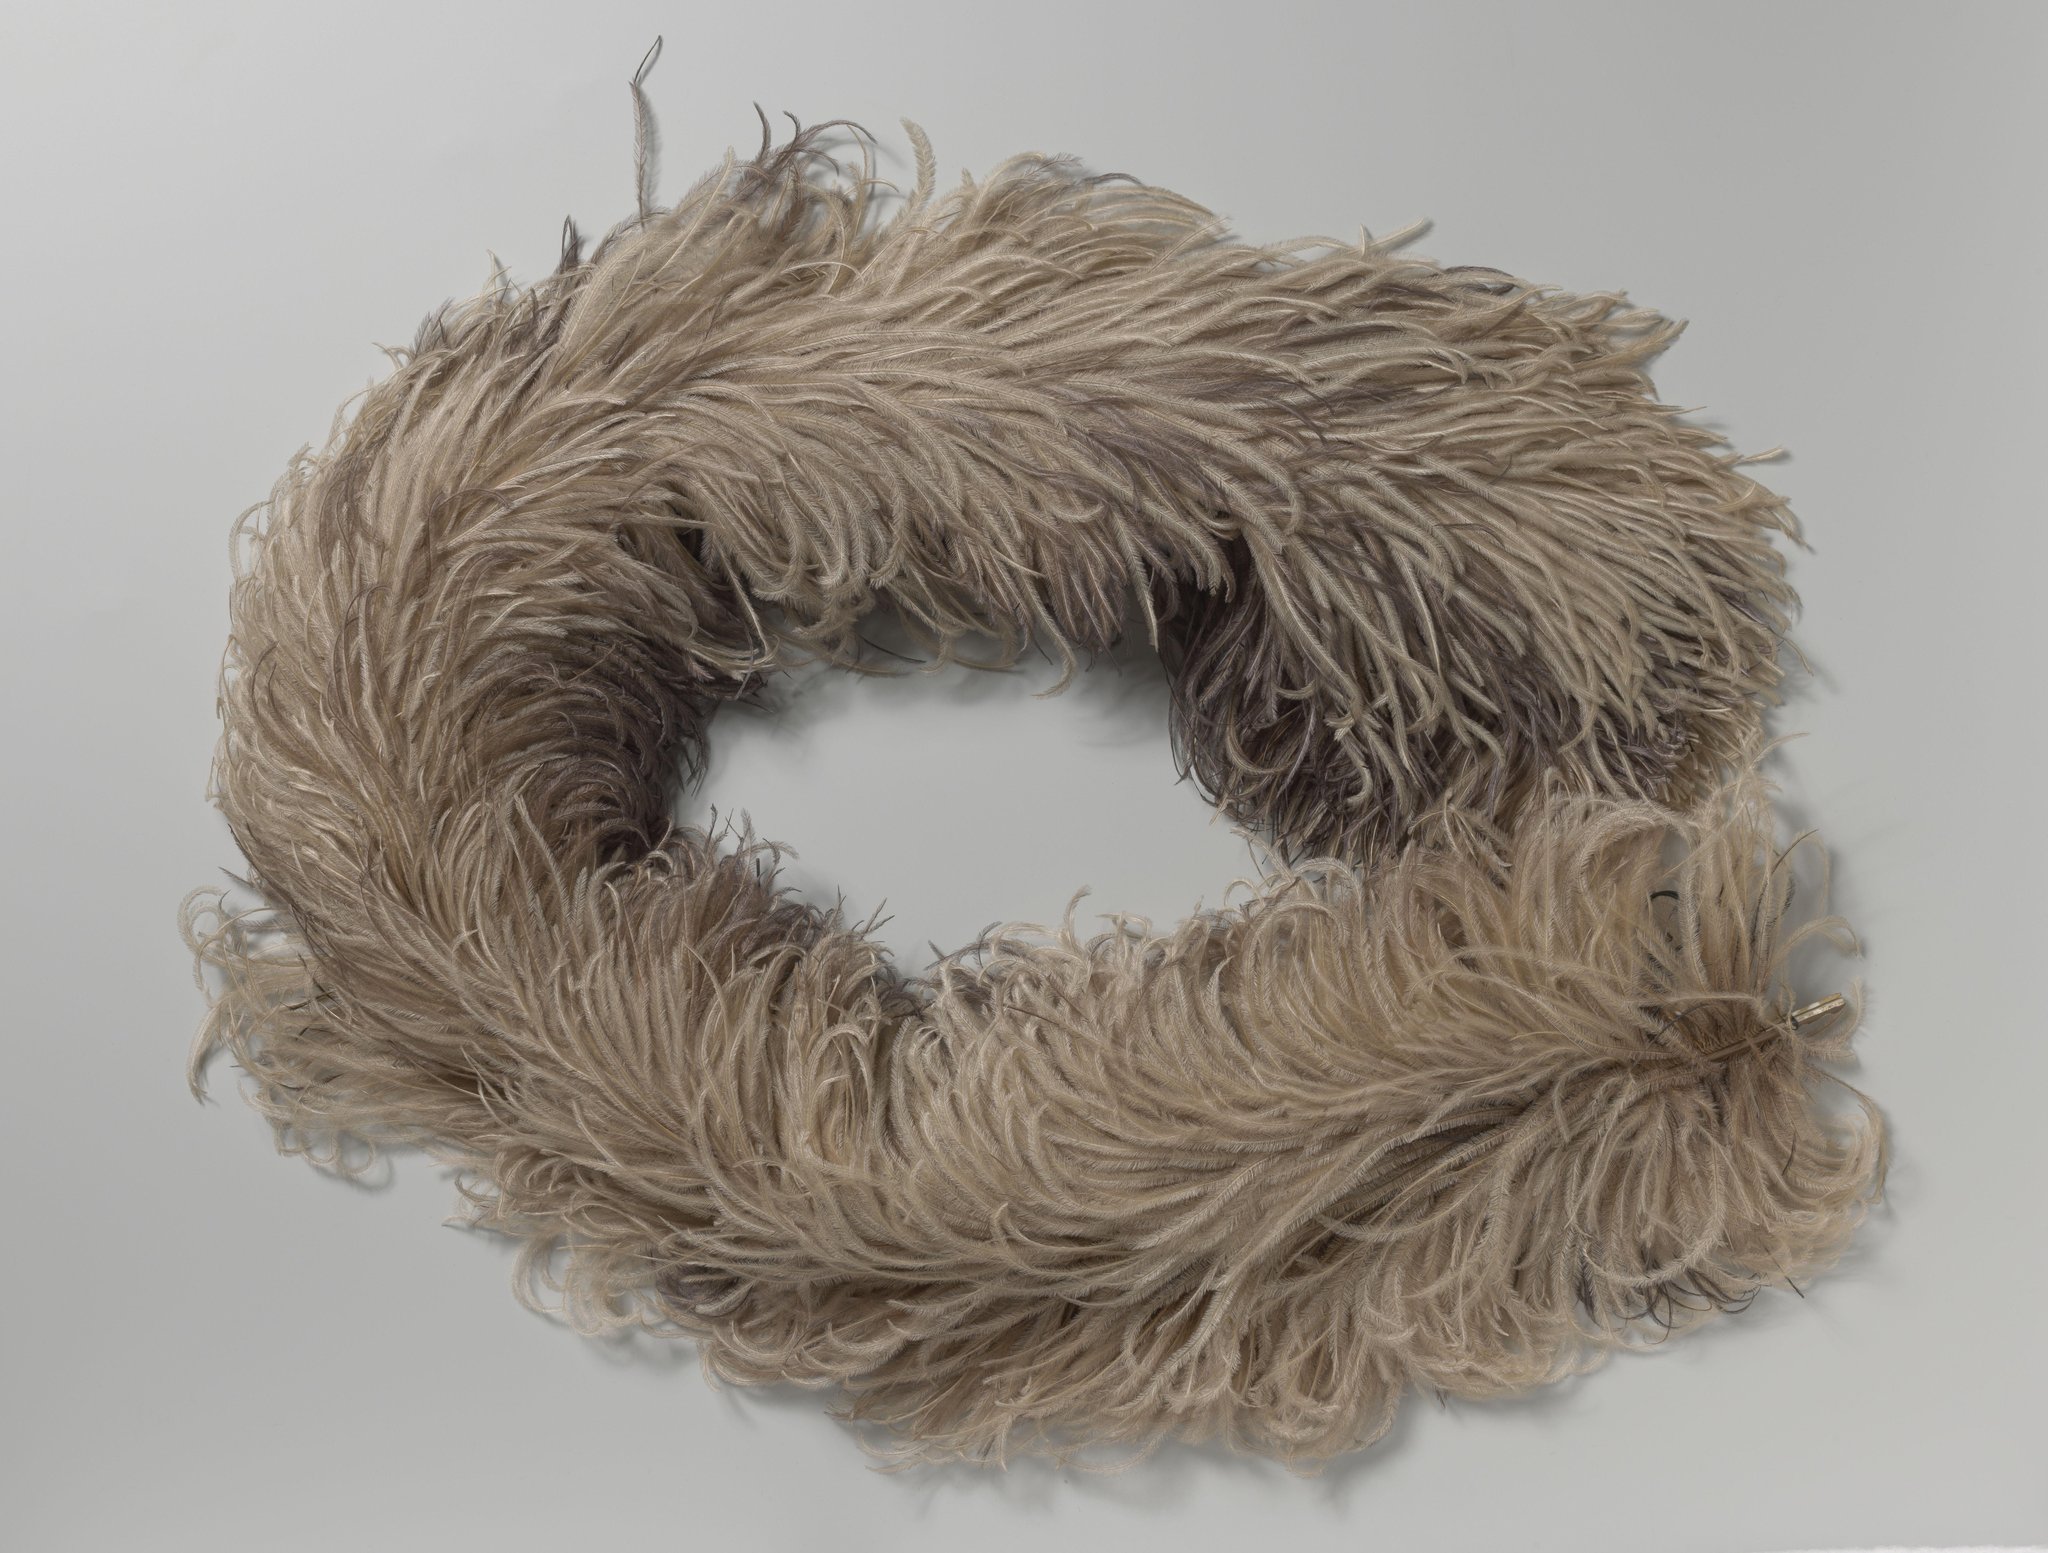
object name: hoedengarneersel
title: Struisveer in bruin en wit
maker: Anonymous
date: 1895-1915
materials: metal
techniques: painting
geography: western europe